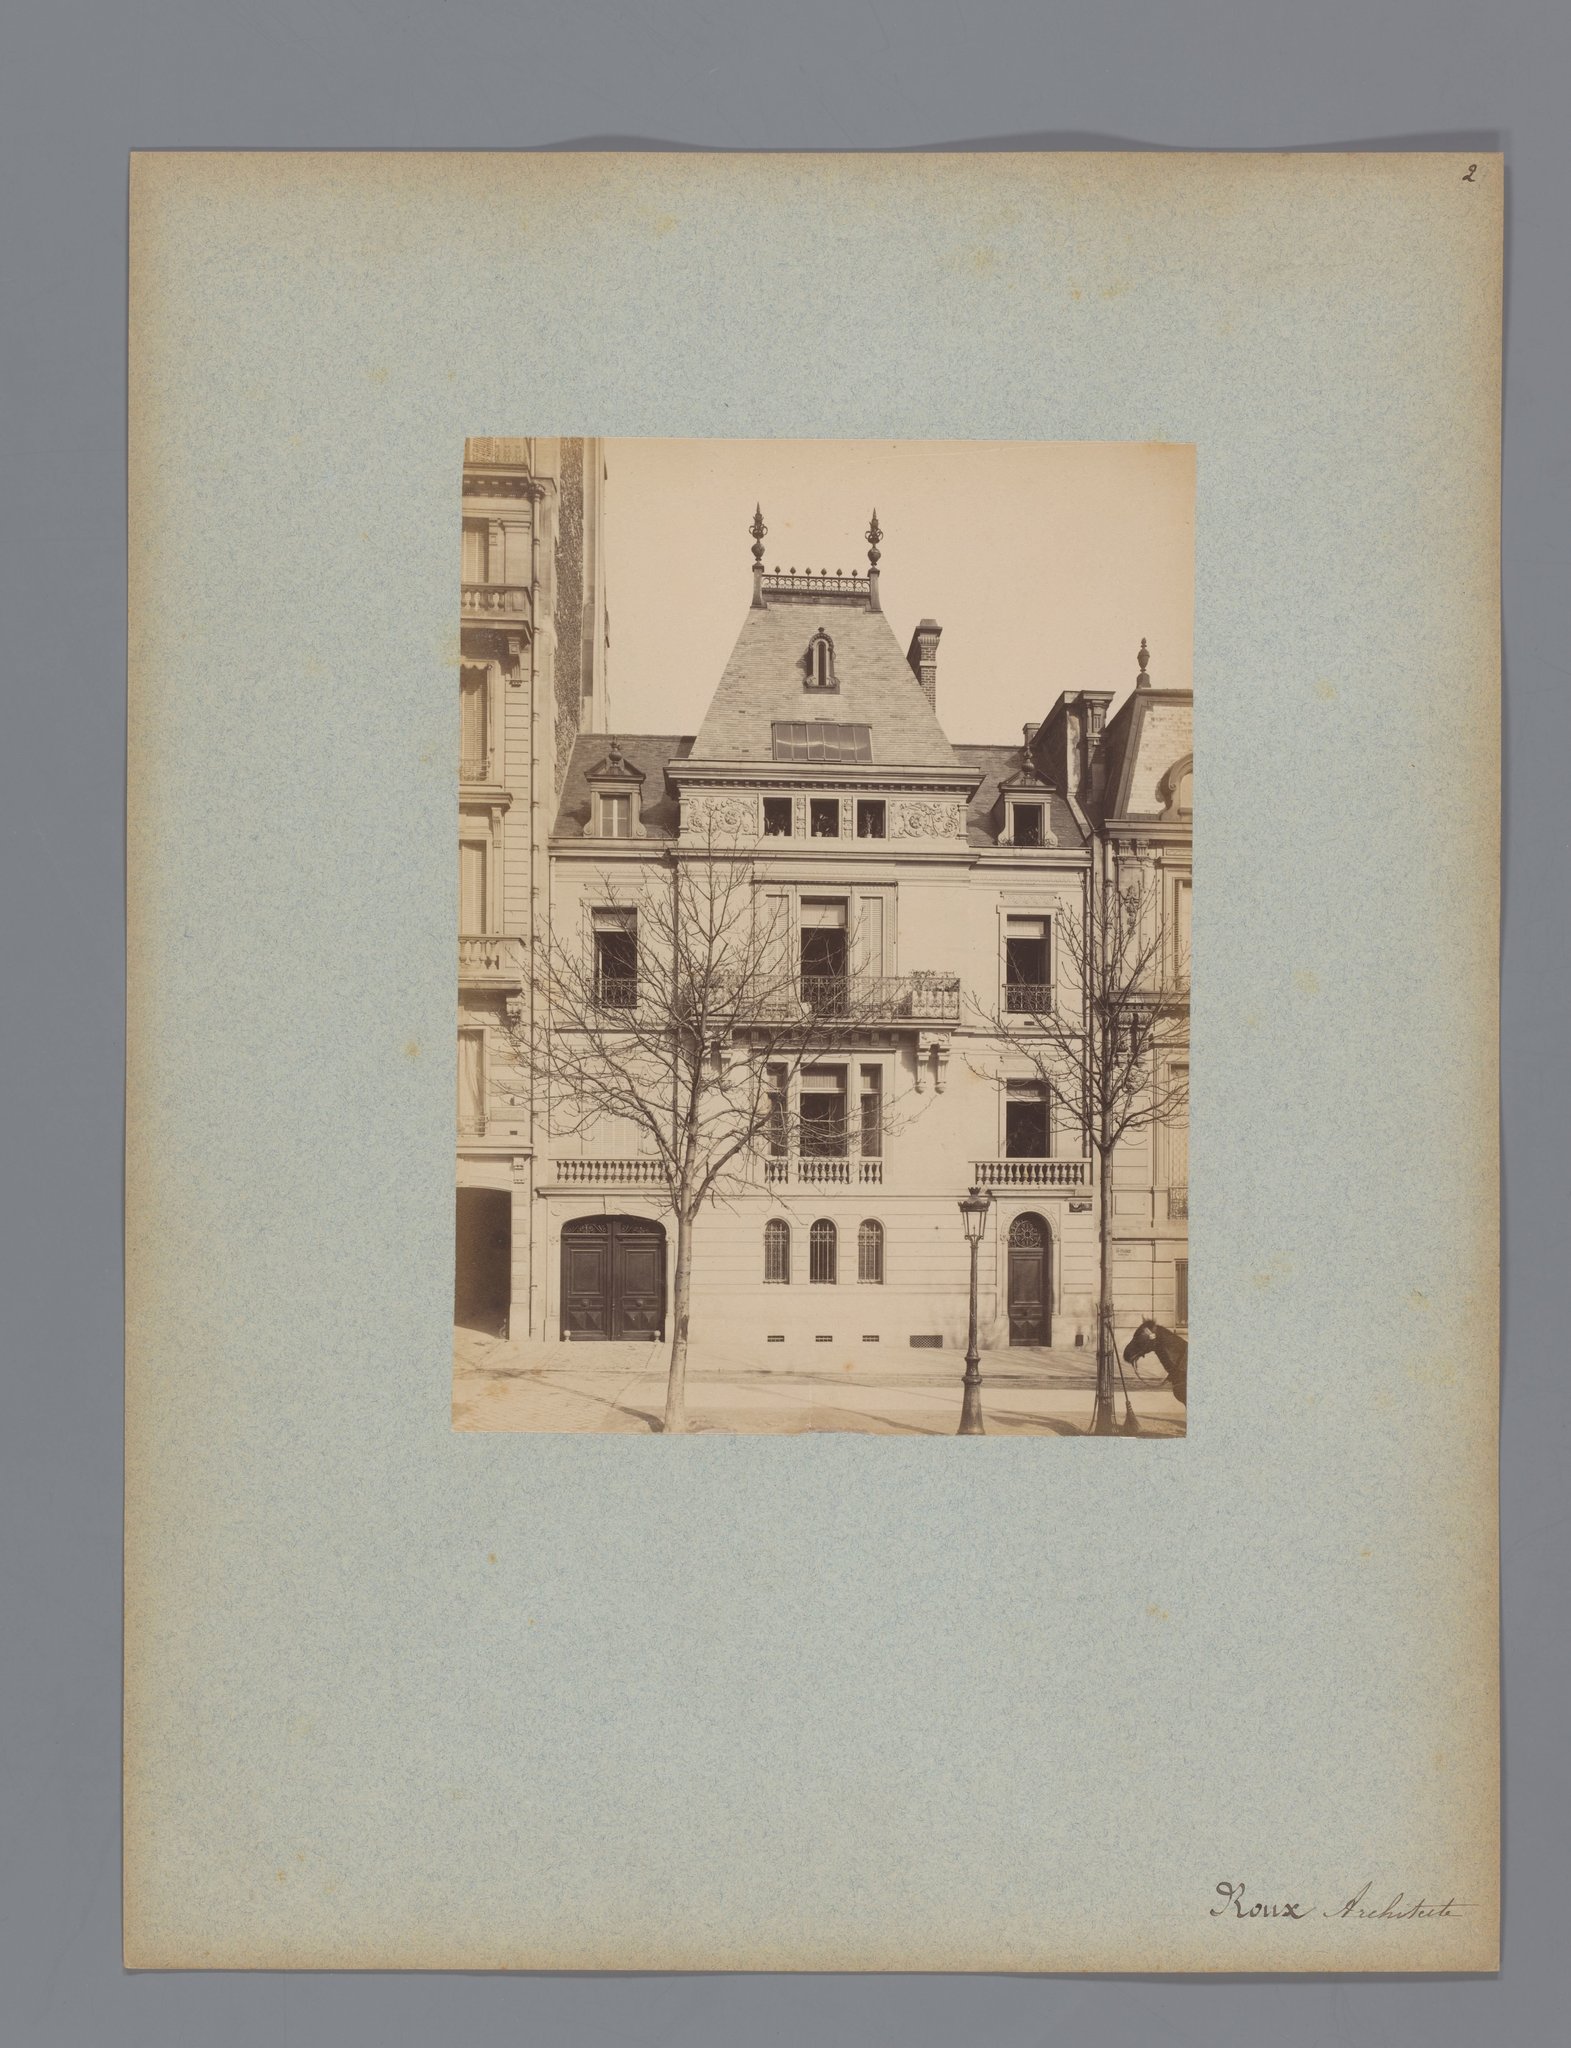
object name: photograph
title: Façade van een woonhuis in Parijs, ontworpen door Louis-François Roux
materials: photographic support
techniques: albumen print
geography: paris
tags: façade (of house or building), paris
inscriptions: name: ‘Roux Architecte’, number: ‘2’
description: Deze foto maakt deel uit van een omslag met 35 foto's en een titelblad.